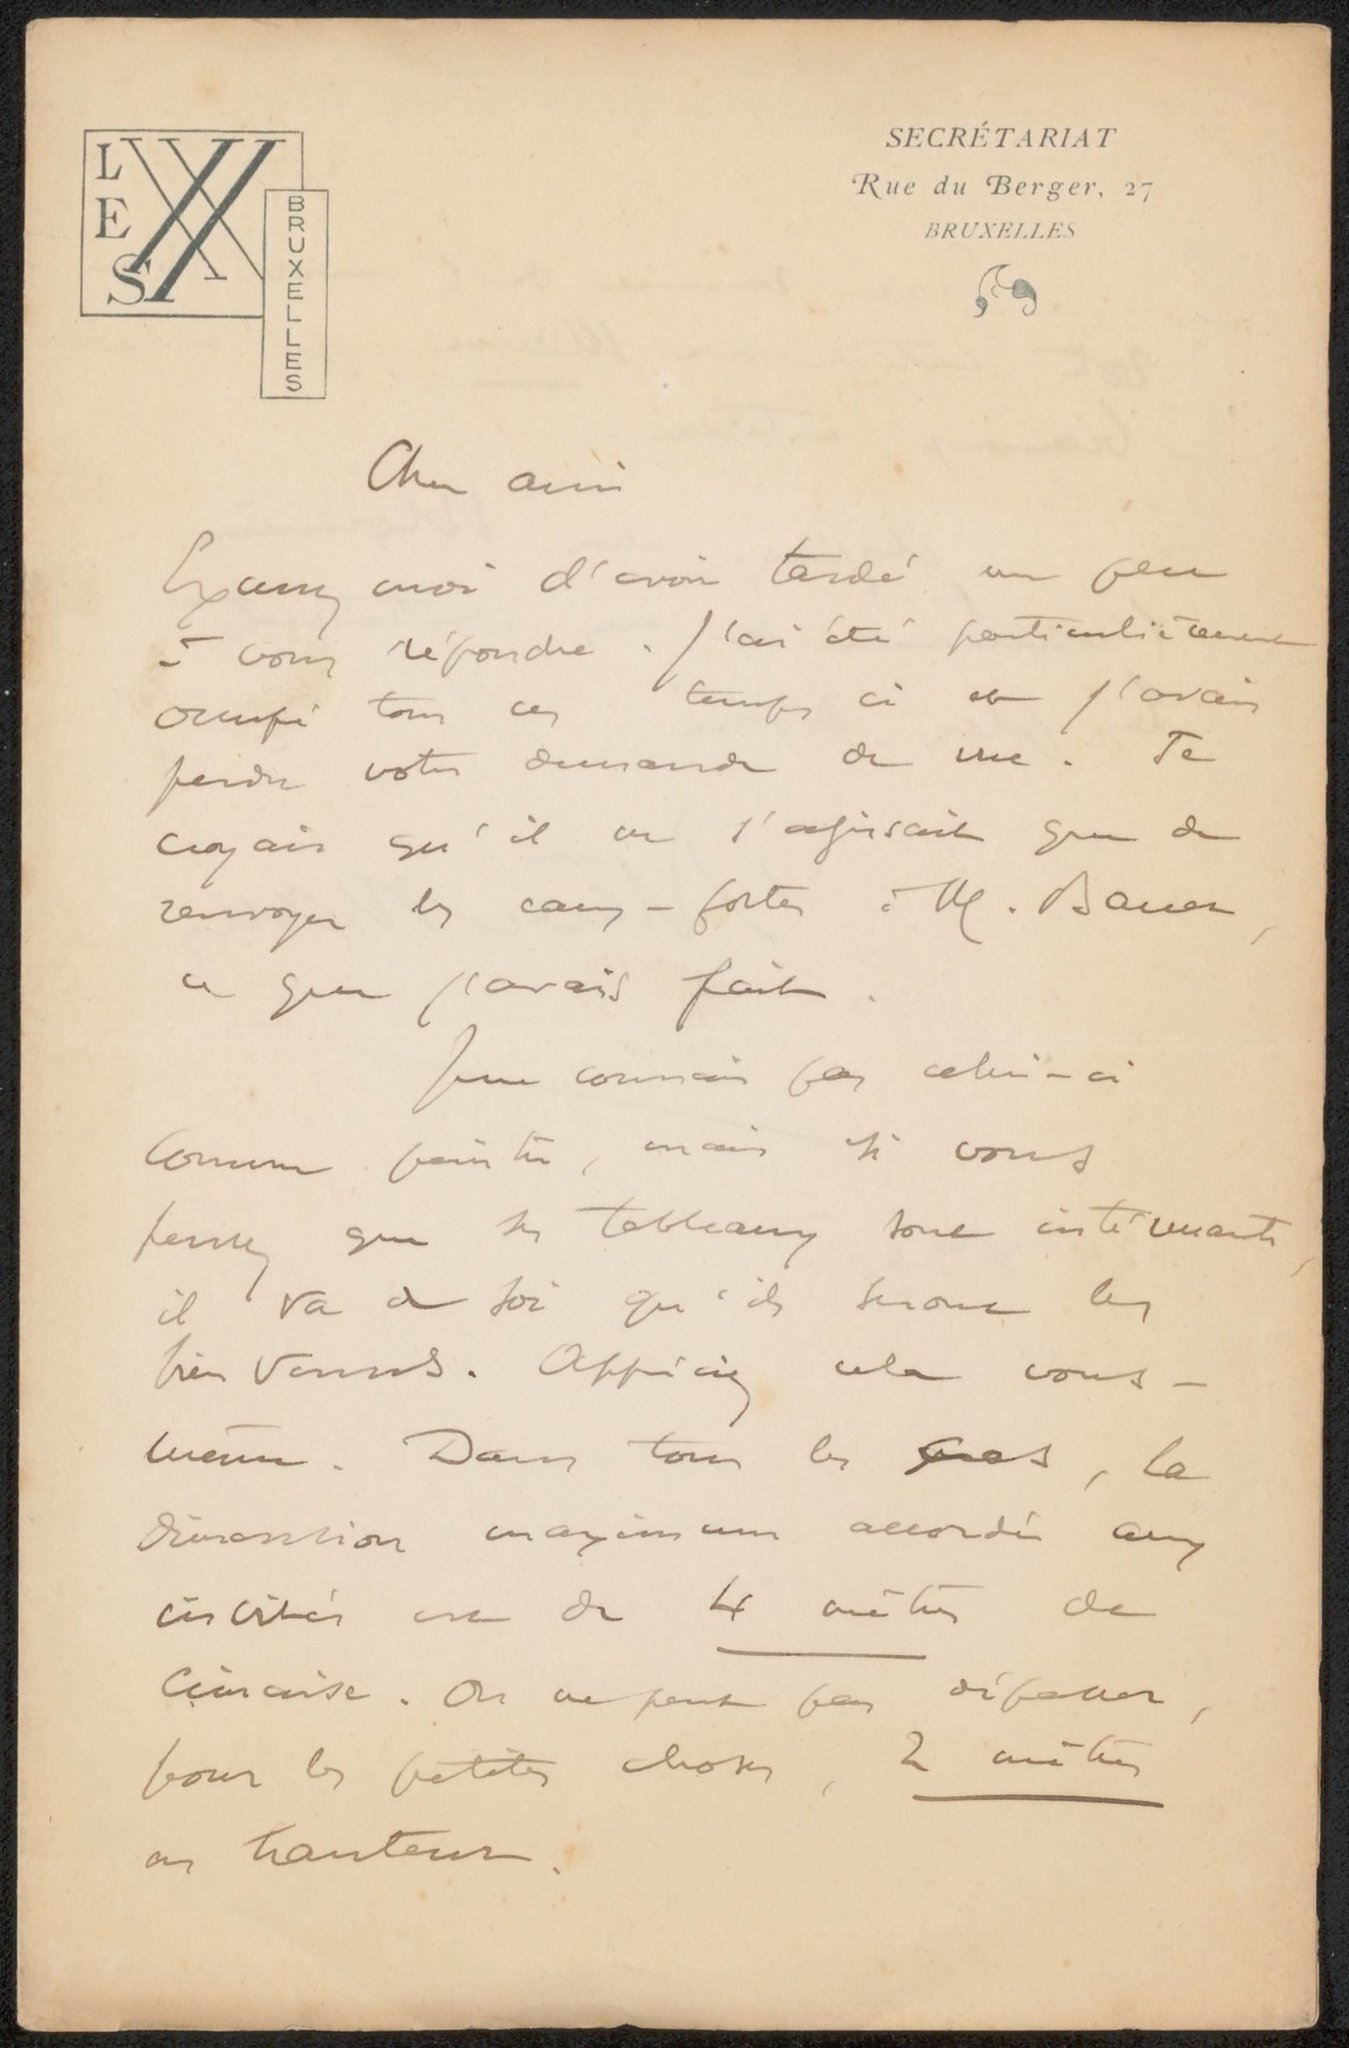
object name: letter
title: Brief aan Philip Zilcken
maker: octave maus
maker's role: painter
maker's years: 1856-1919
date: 1890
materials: ink, paper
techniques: pen, printing, writing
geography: brussels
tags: anton mauve, amsterdam, print maker, draughtsman, marius bauer, painter, philip zilcken, the graphic arts, painting (including book-illumination, miniature-painting)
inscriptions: collector's mark: ‘RPK’